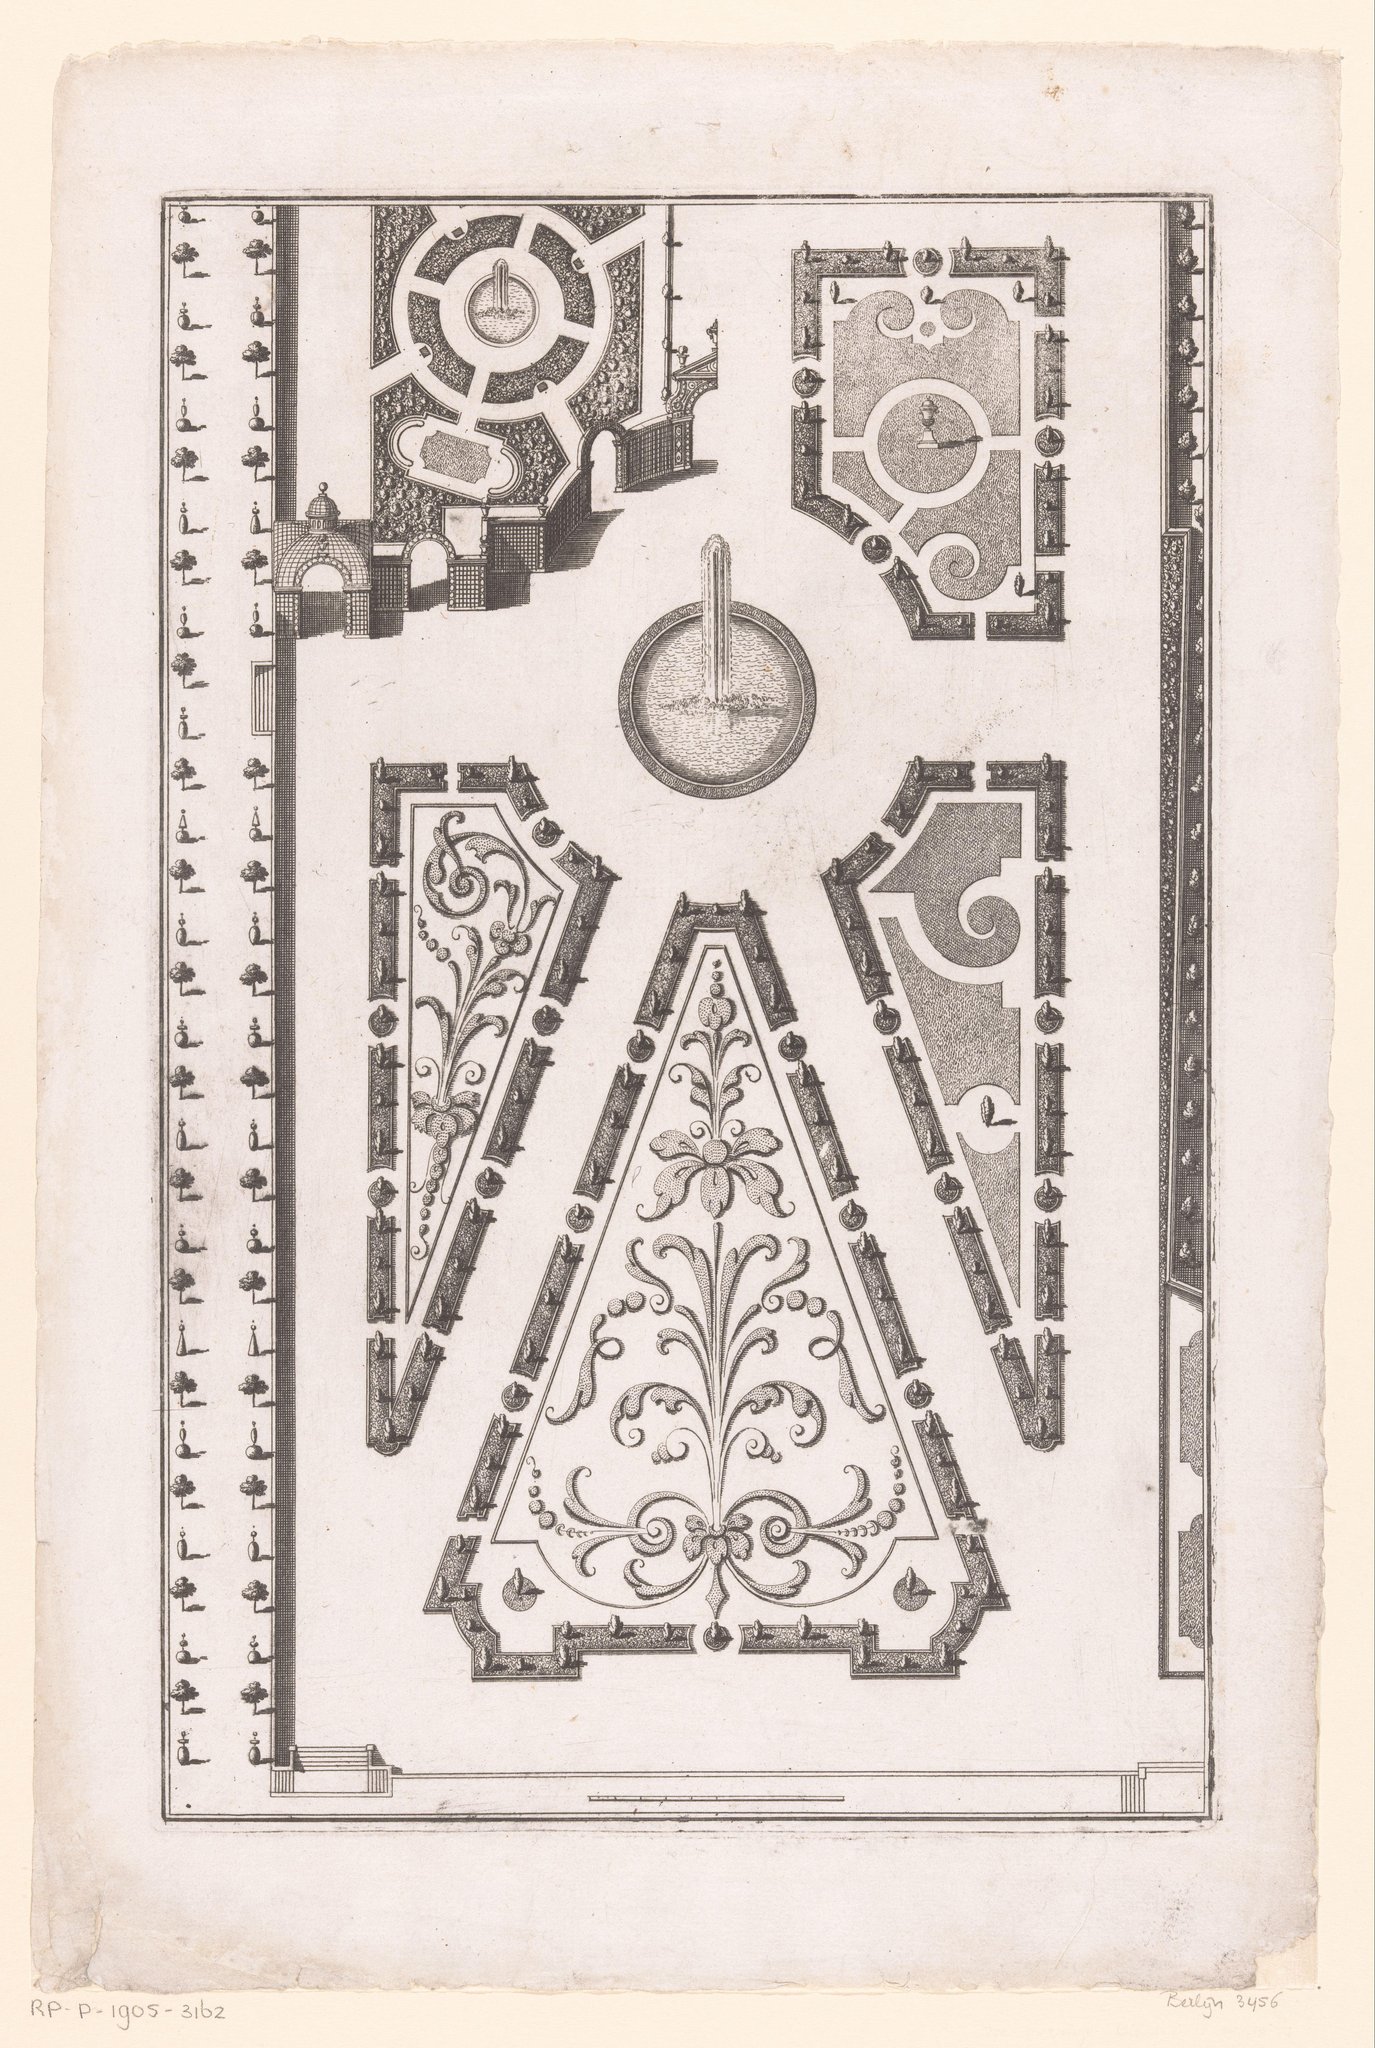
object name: print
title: Plattegrond van tuin met driehoekige parterres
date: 1650-1700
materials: paper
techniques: etching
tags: plan, map of garden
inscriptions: collector's mark: Lugt 2228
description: Drie driehoekige parterres afgescheiden door paden en daarboven een ronde fontein. Links lanen met bomen. Boven de fontein twee parterres met een fontein en een vaas, links boven afgescheiden door een omheining.